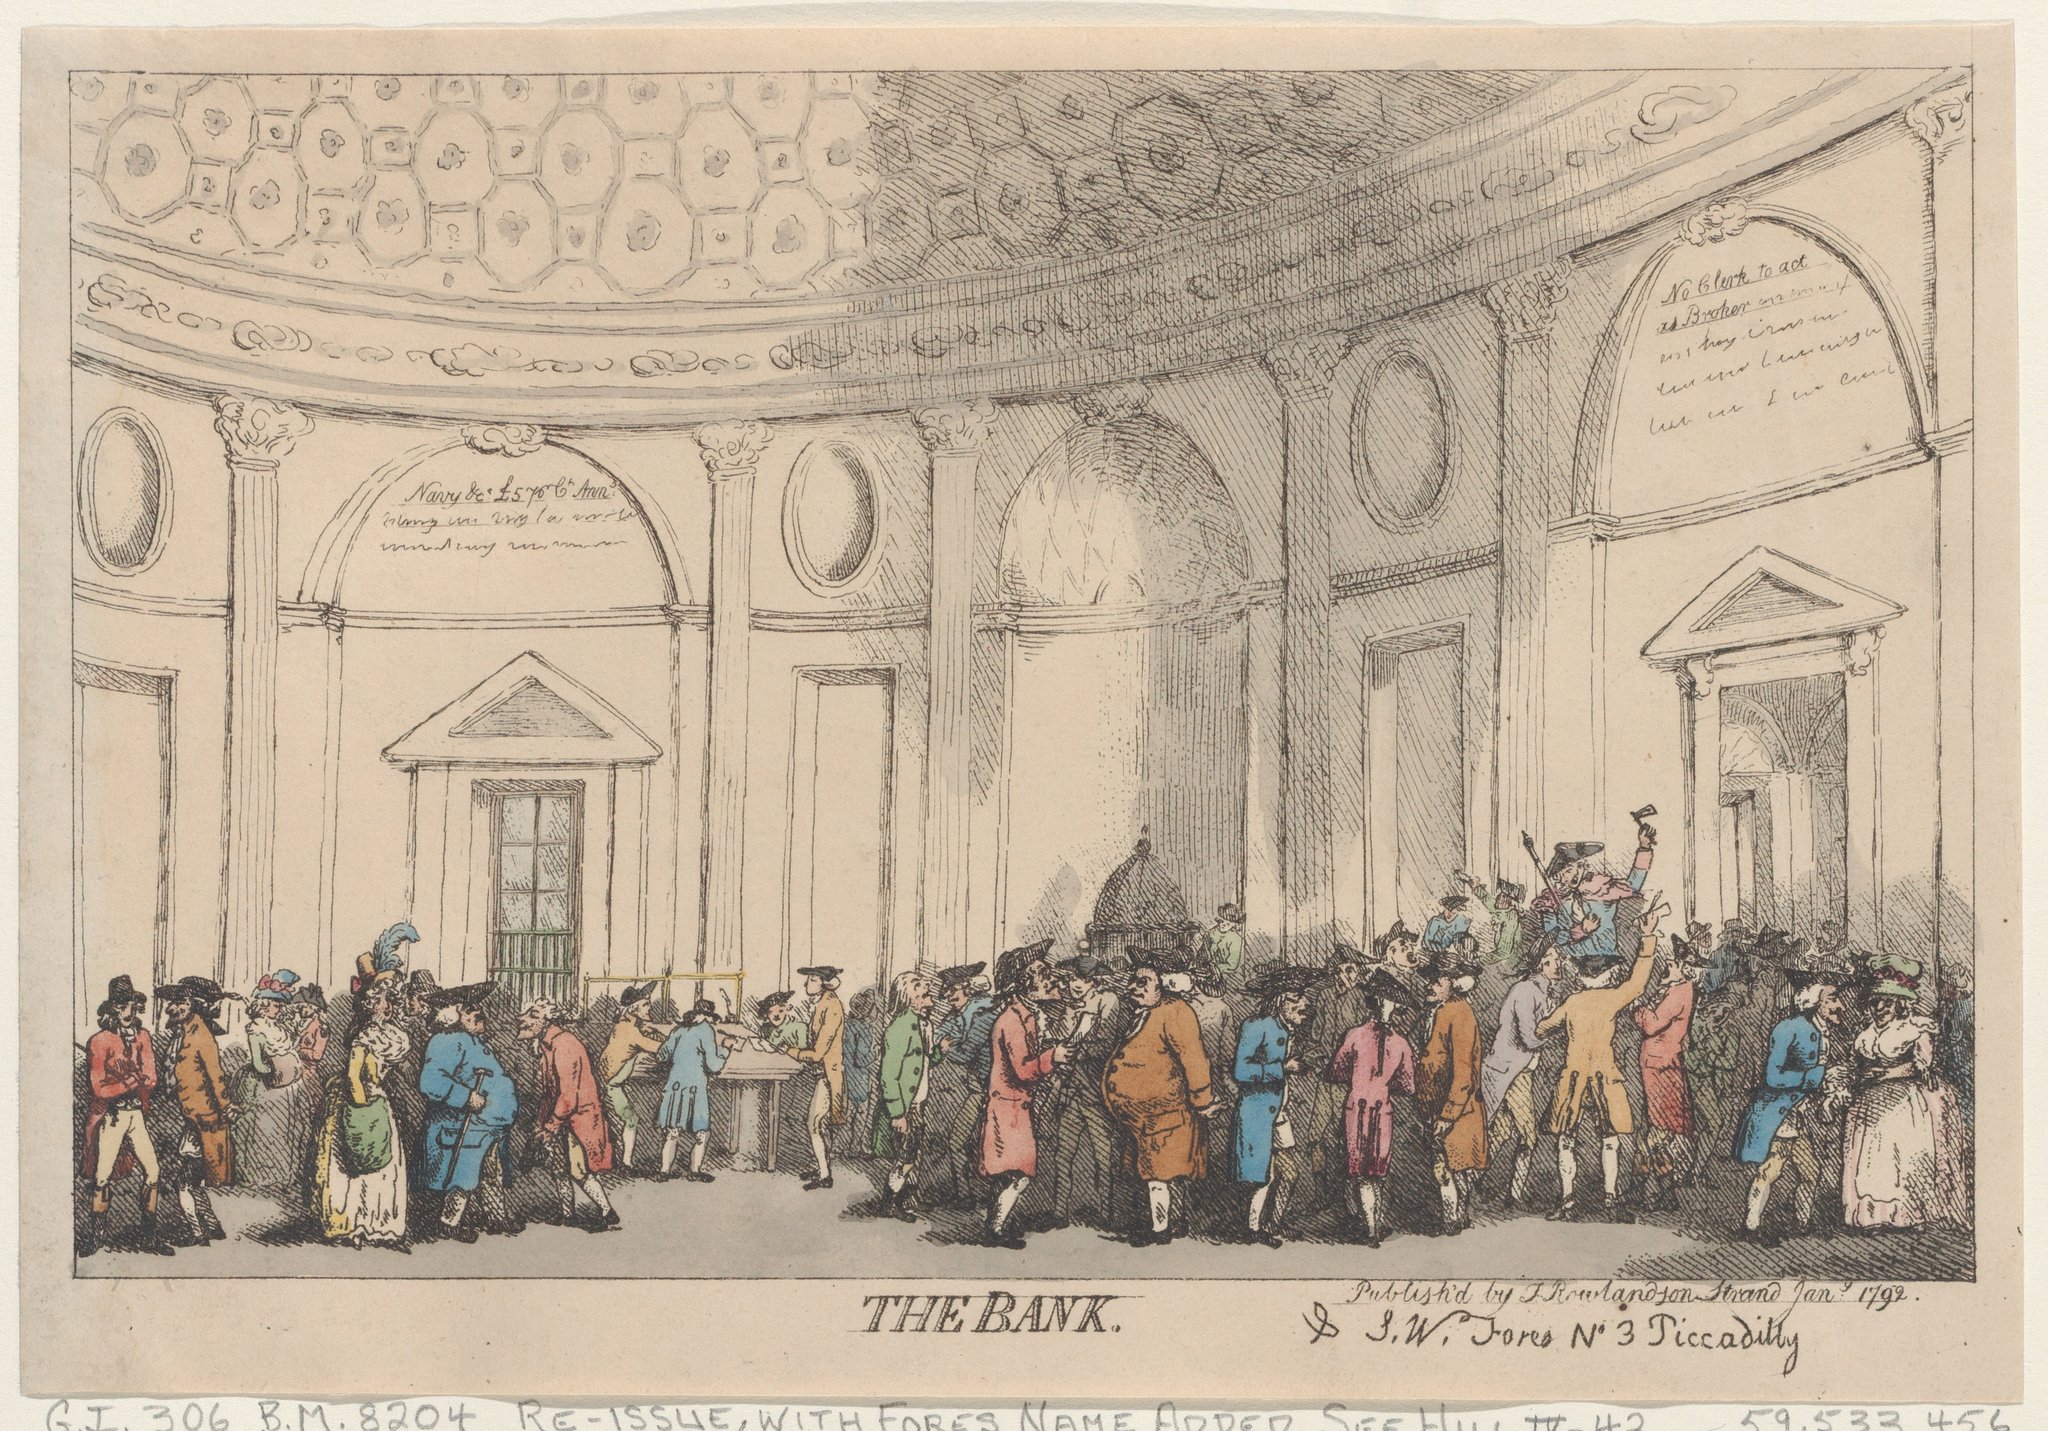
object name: print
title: The Bank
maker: thomas rowlandson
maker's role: artist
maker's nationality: british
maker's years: 1757-1827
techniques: etching